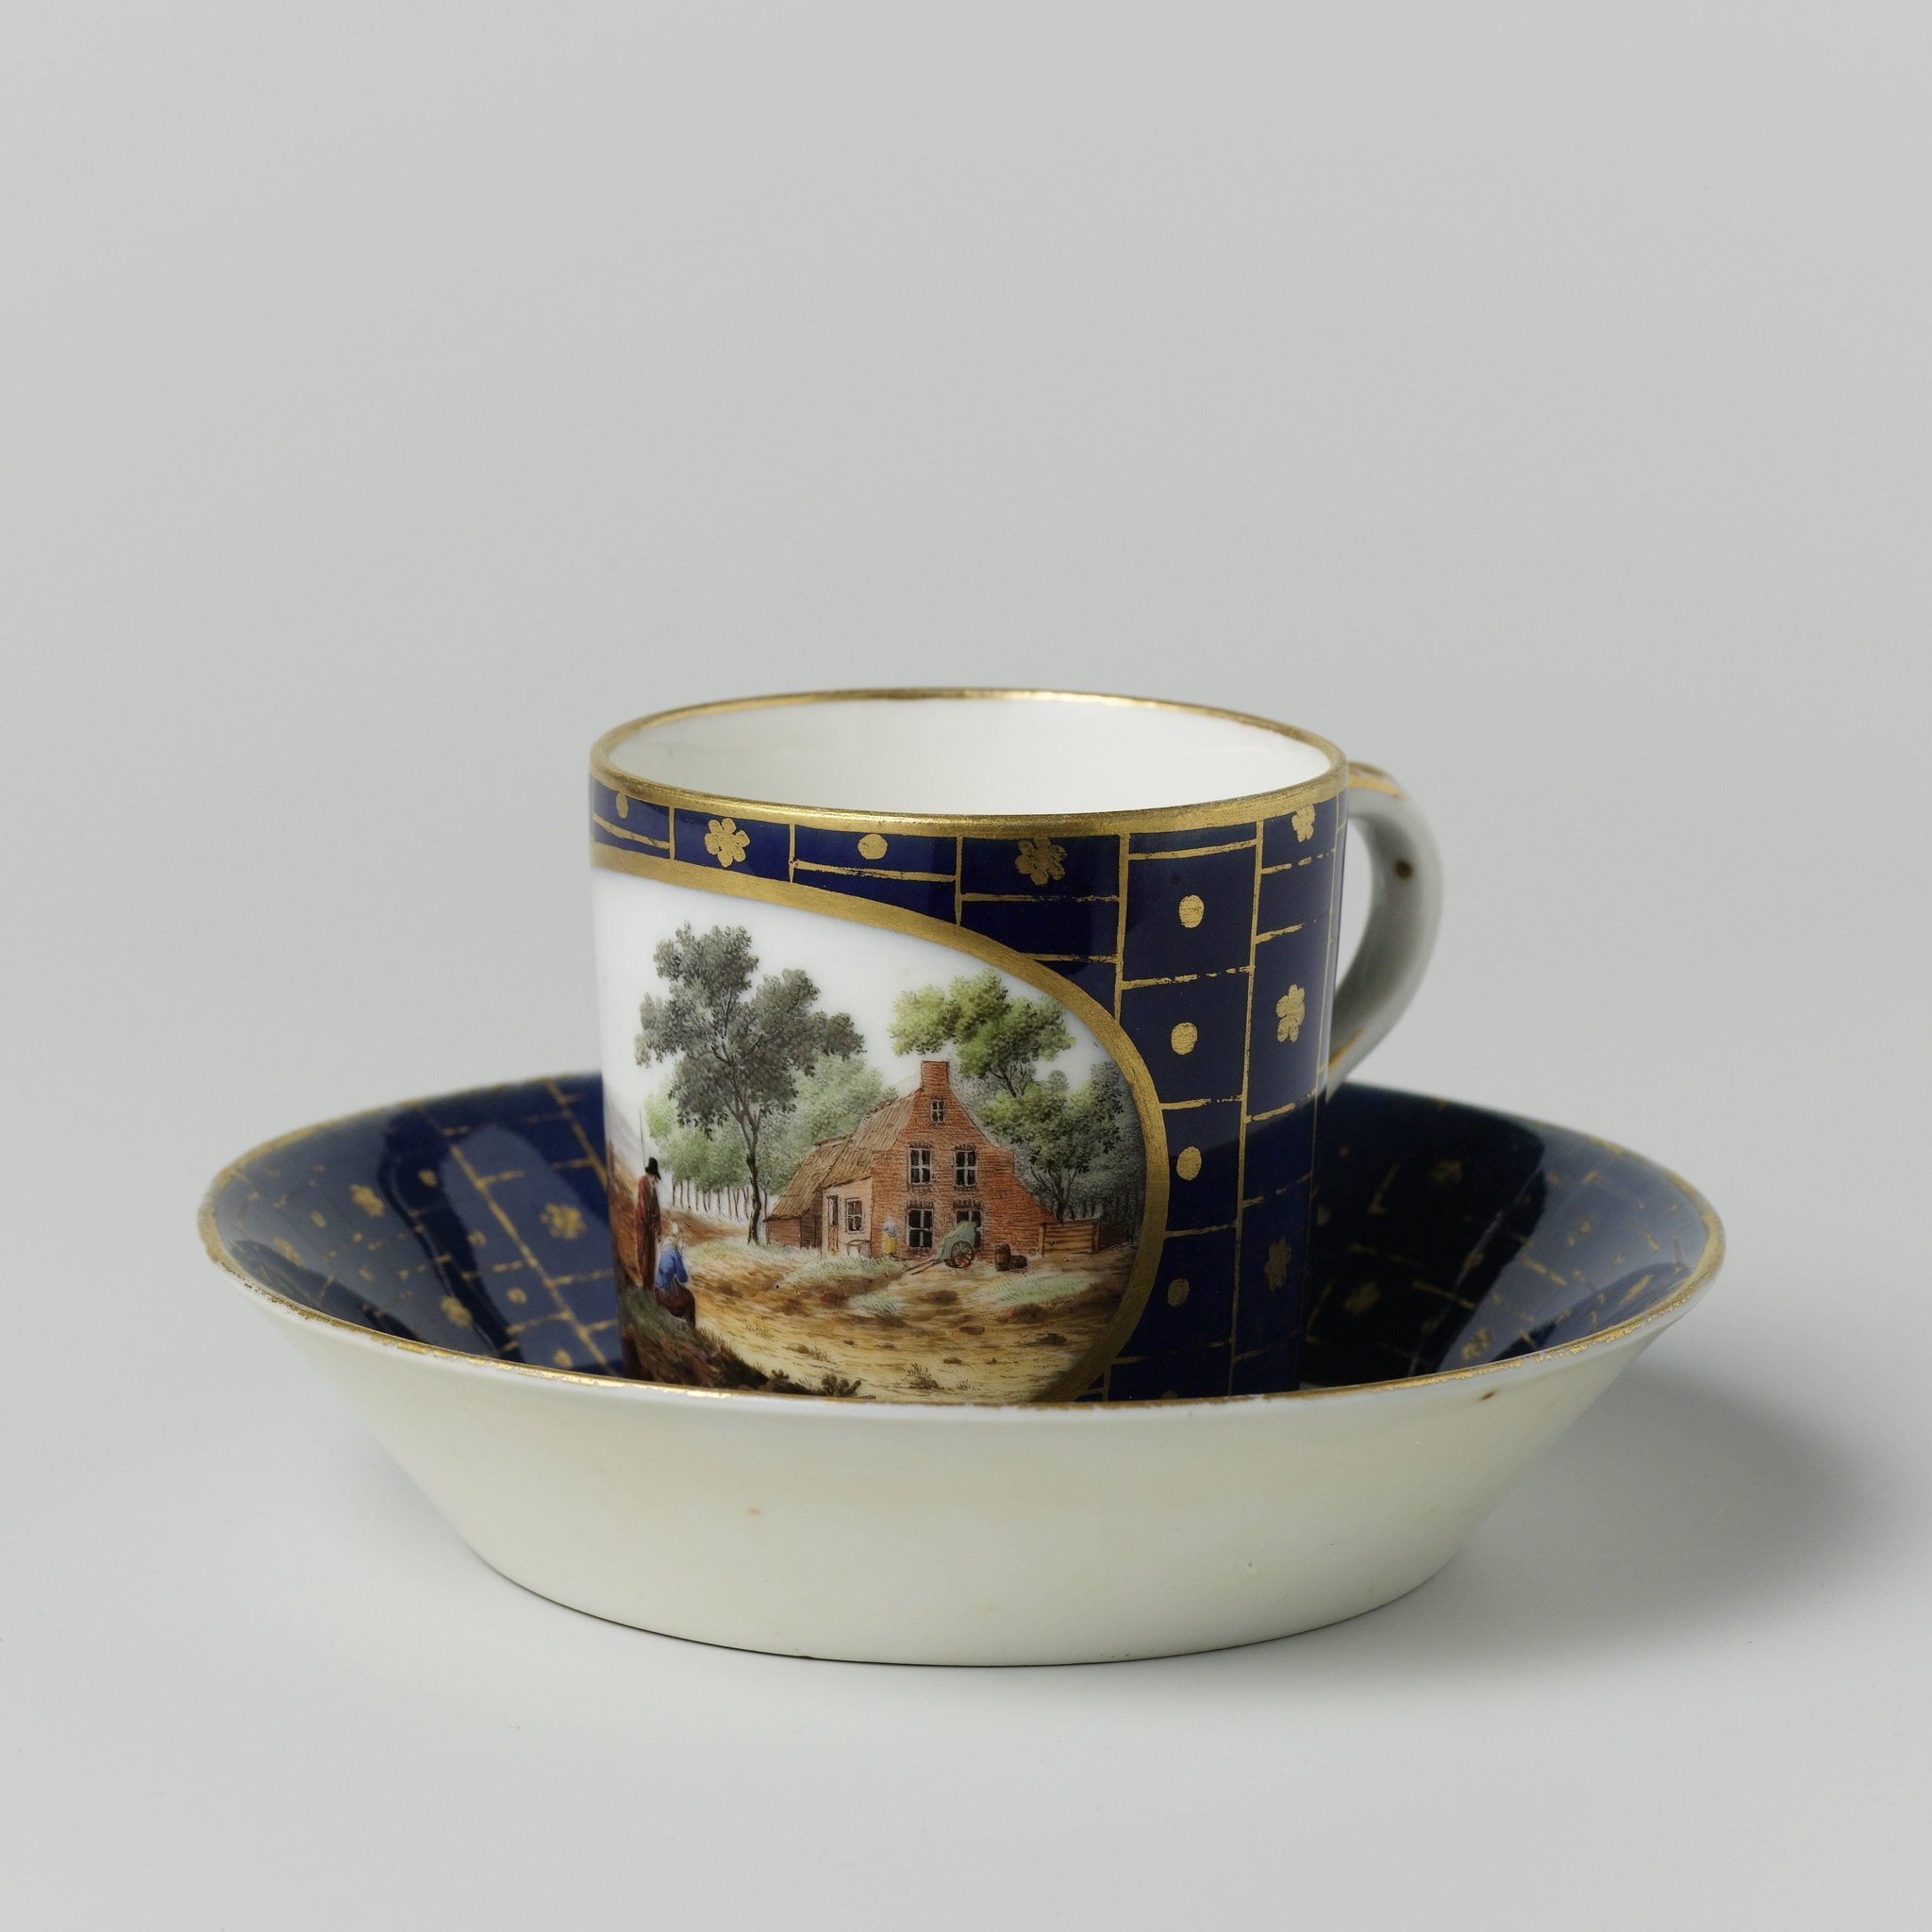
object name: kop en schotel, kop en schotel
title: Cup and saucer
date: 1784-1809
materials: porcelain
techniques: painted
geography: ouder-amstel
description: Porceleinfabriek aan den Amstel Ouder-Amstel, c. 1784–1809 hard-paste porcelain